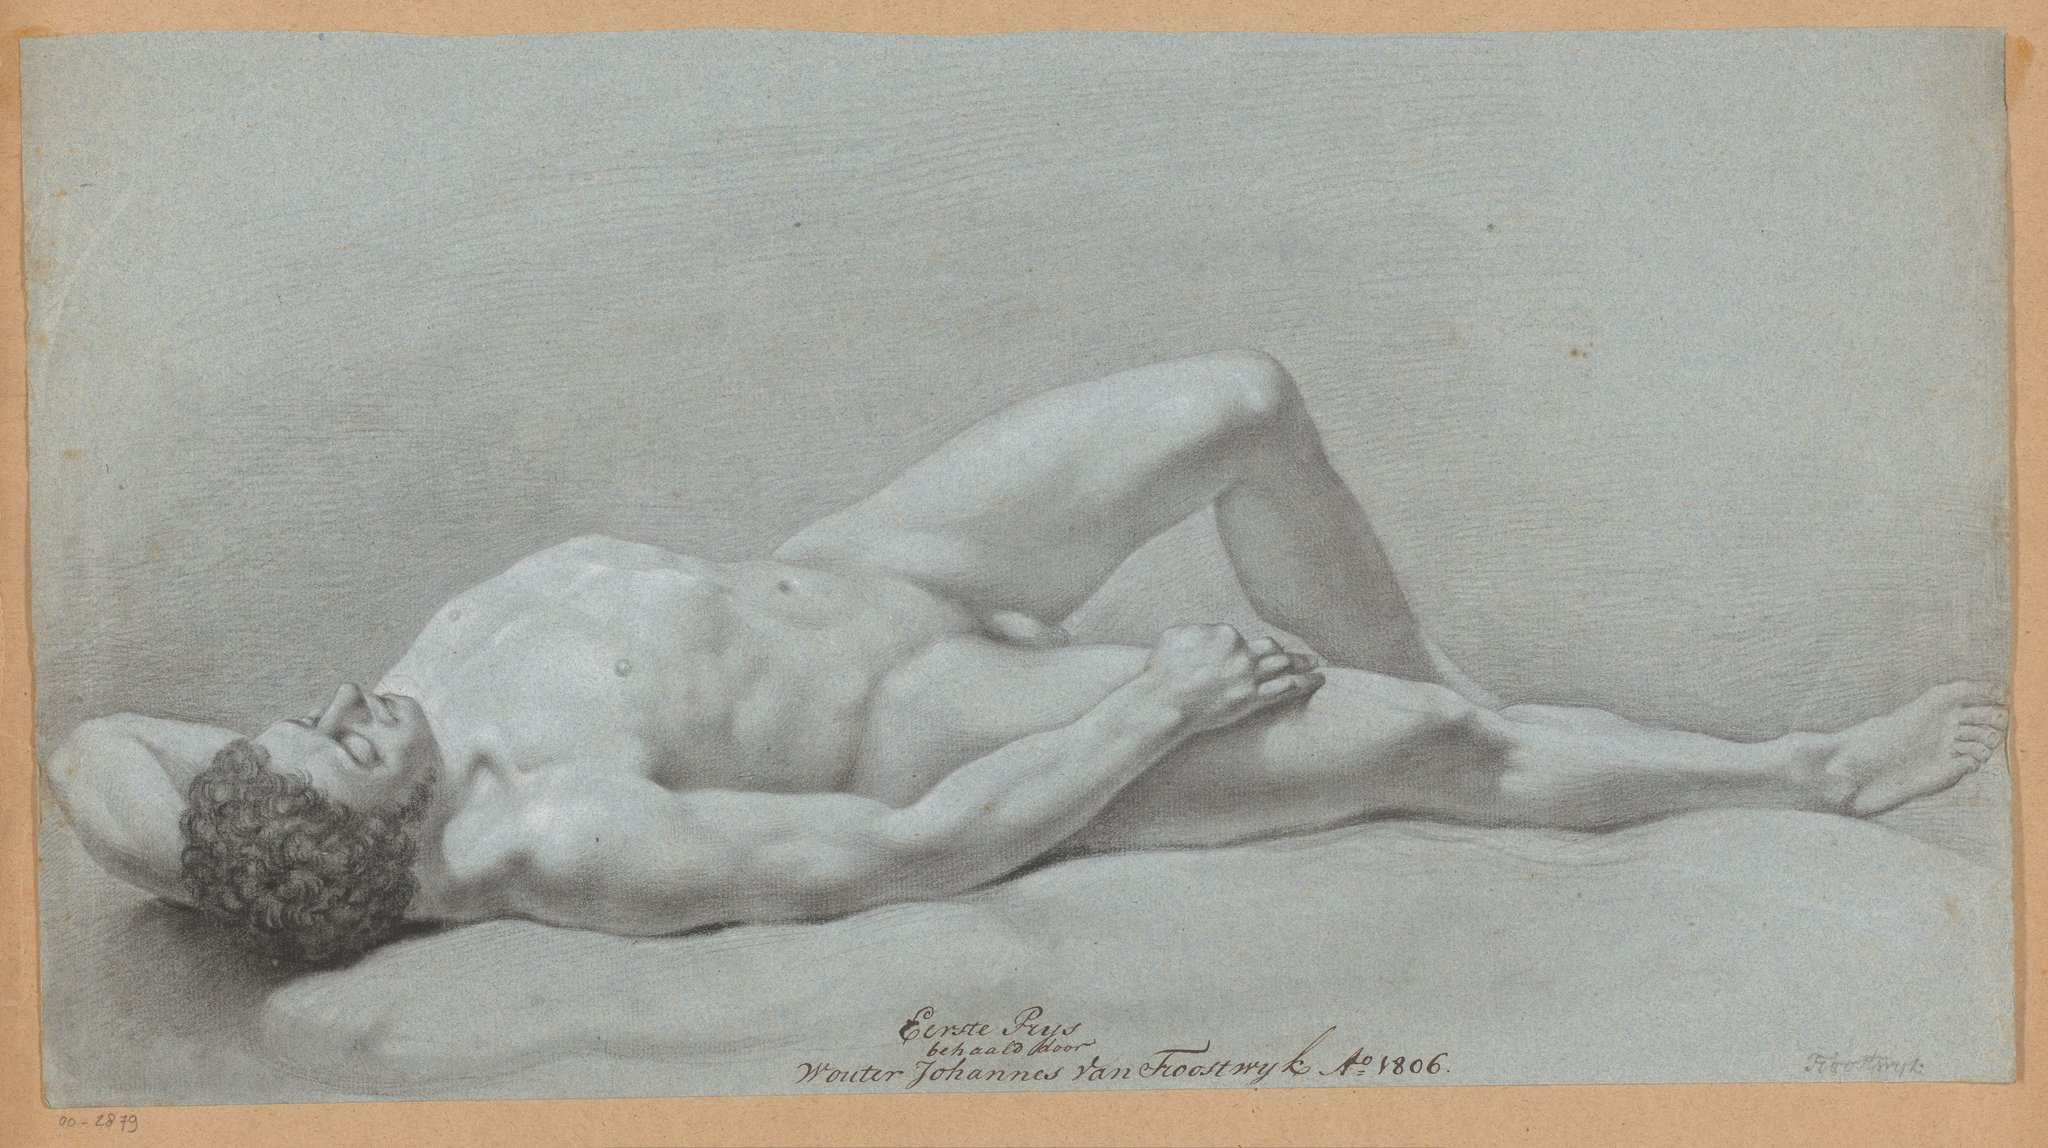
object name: drawing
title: Op de rug liggend mannelijk naakt (1e prijs 1806)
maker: wouter johannes van troostwijk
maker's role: draughtsman, painter, print maker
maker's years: 1782-1810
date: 1806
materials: chalk, paper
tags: lying figure (+ nude human being)